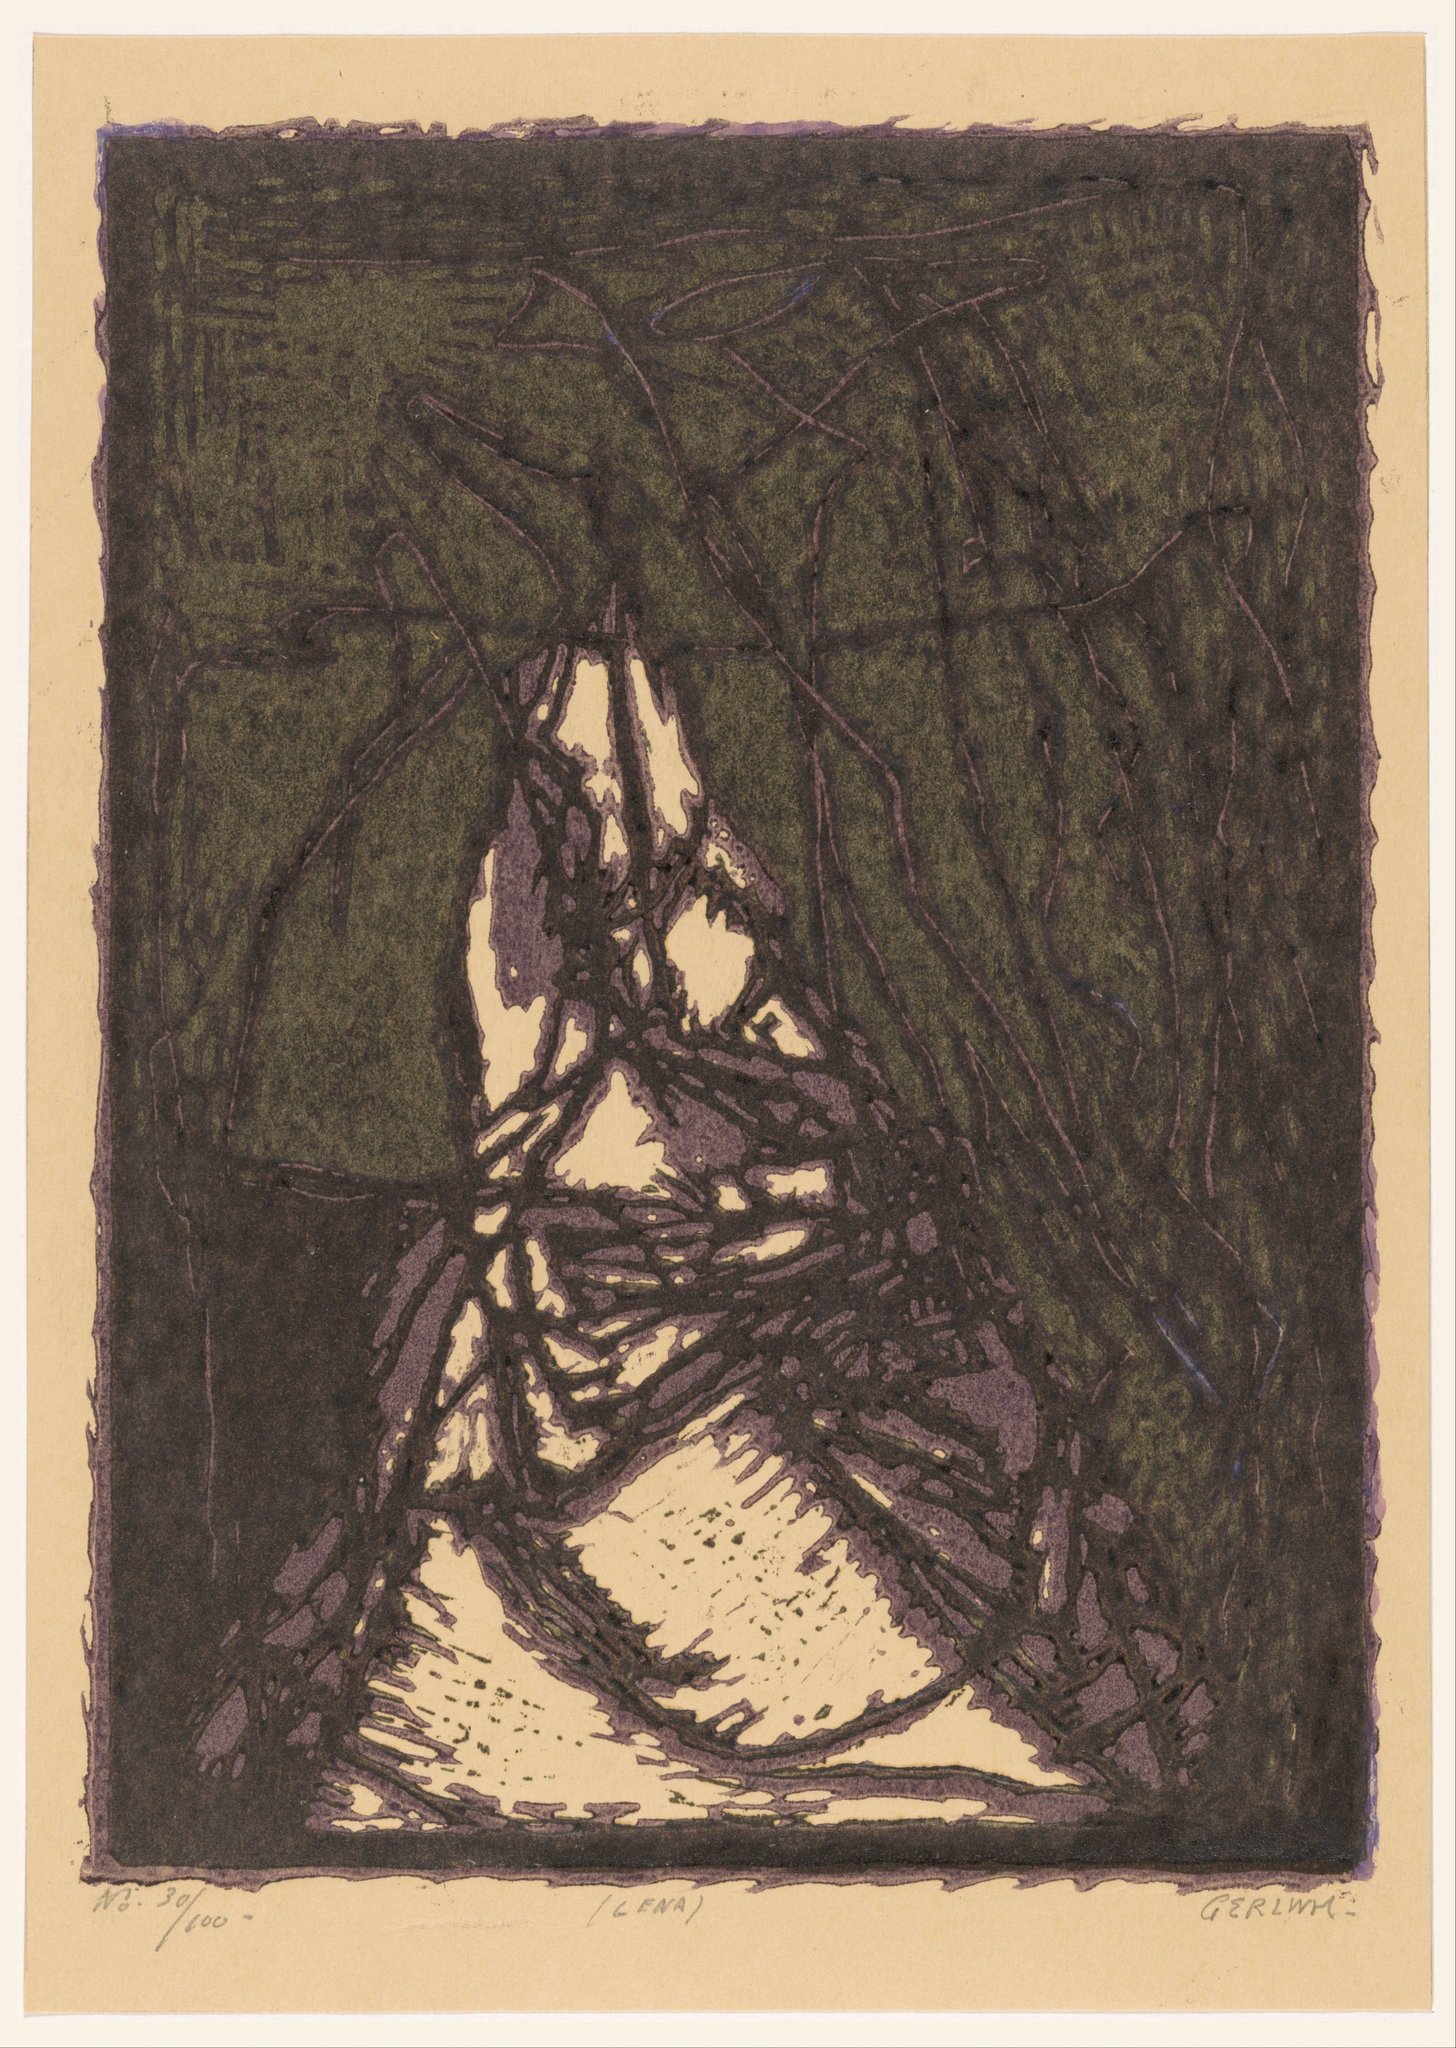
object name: print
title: Lena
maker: ger ladage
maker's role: print maker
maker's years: 1878-1932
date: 1914-1936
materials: paper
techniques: color etching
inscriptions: collector's mark: Lugt 2760, collector's mark: Lugt 2228